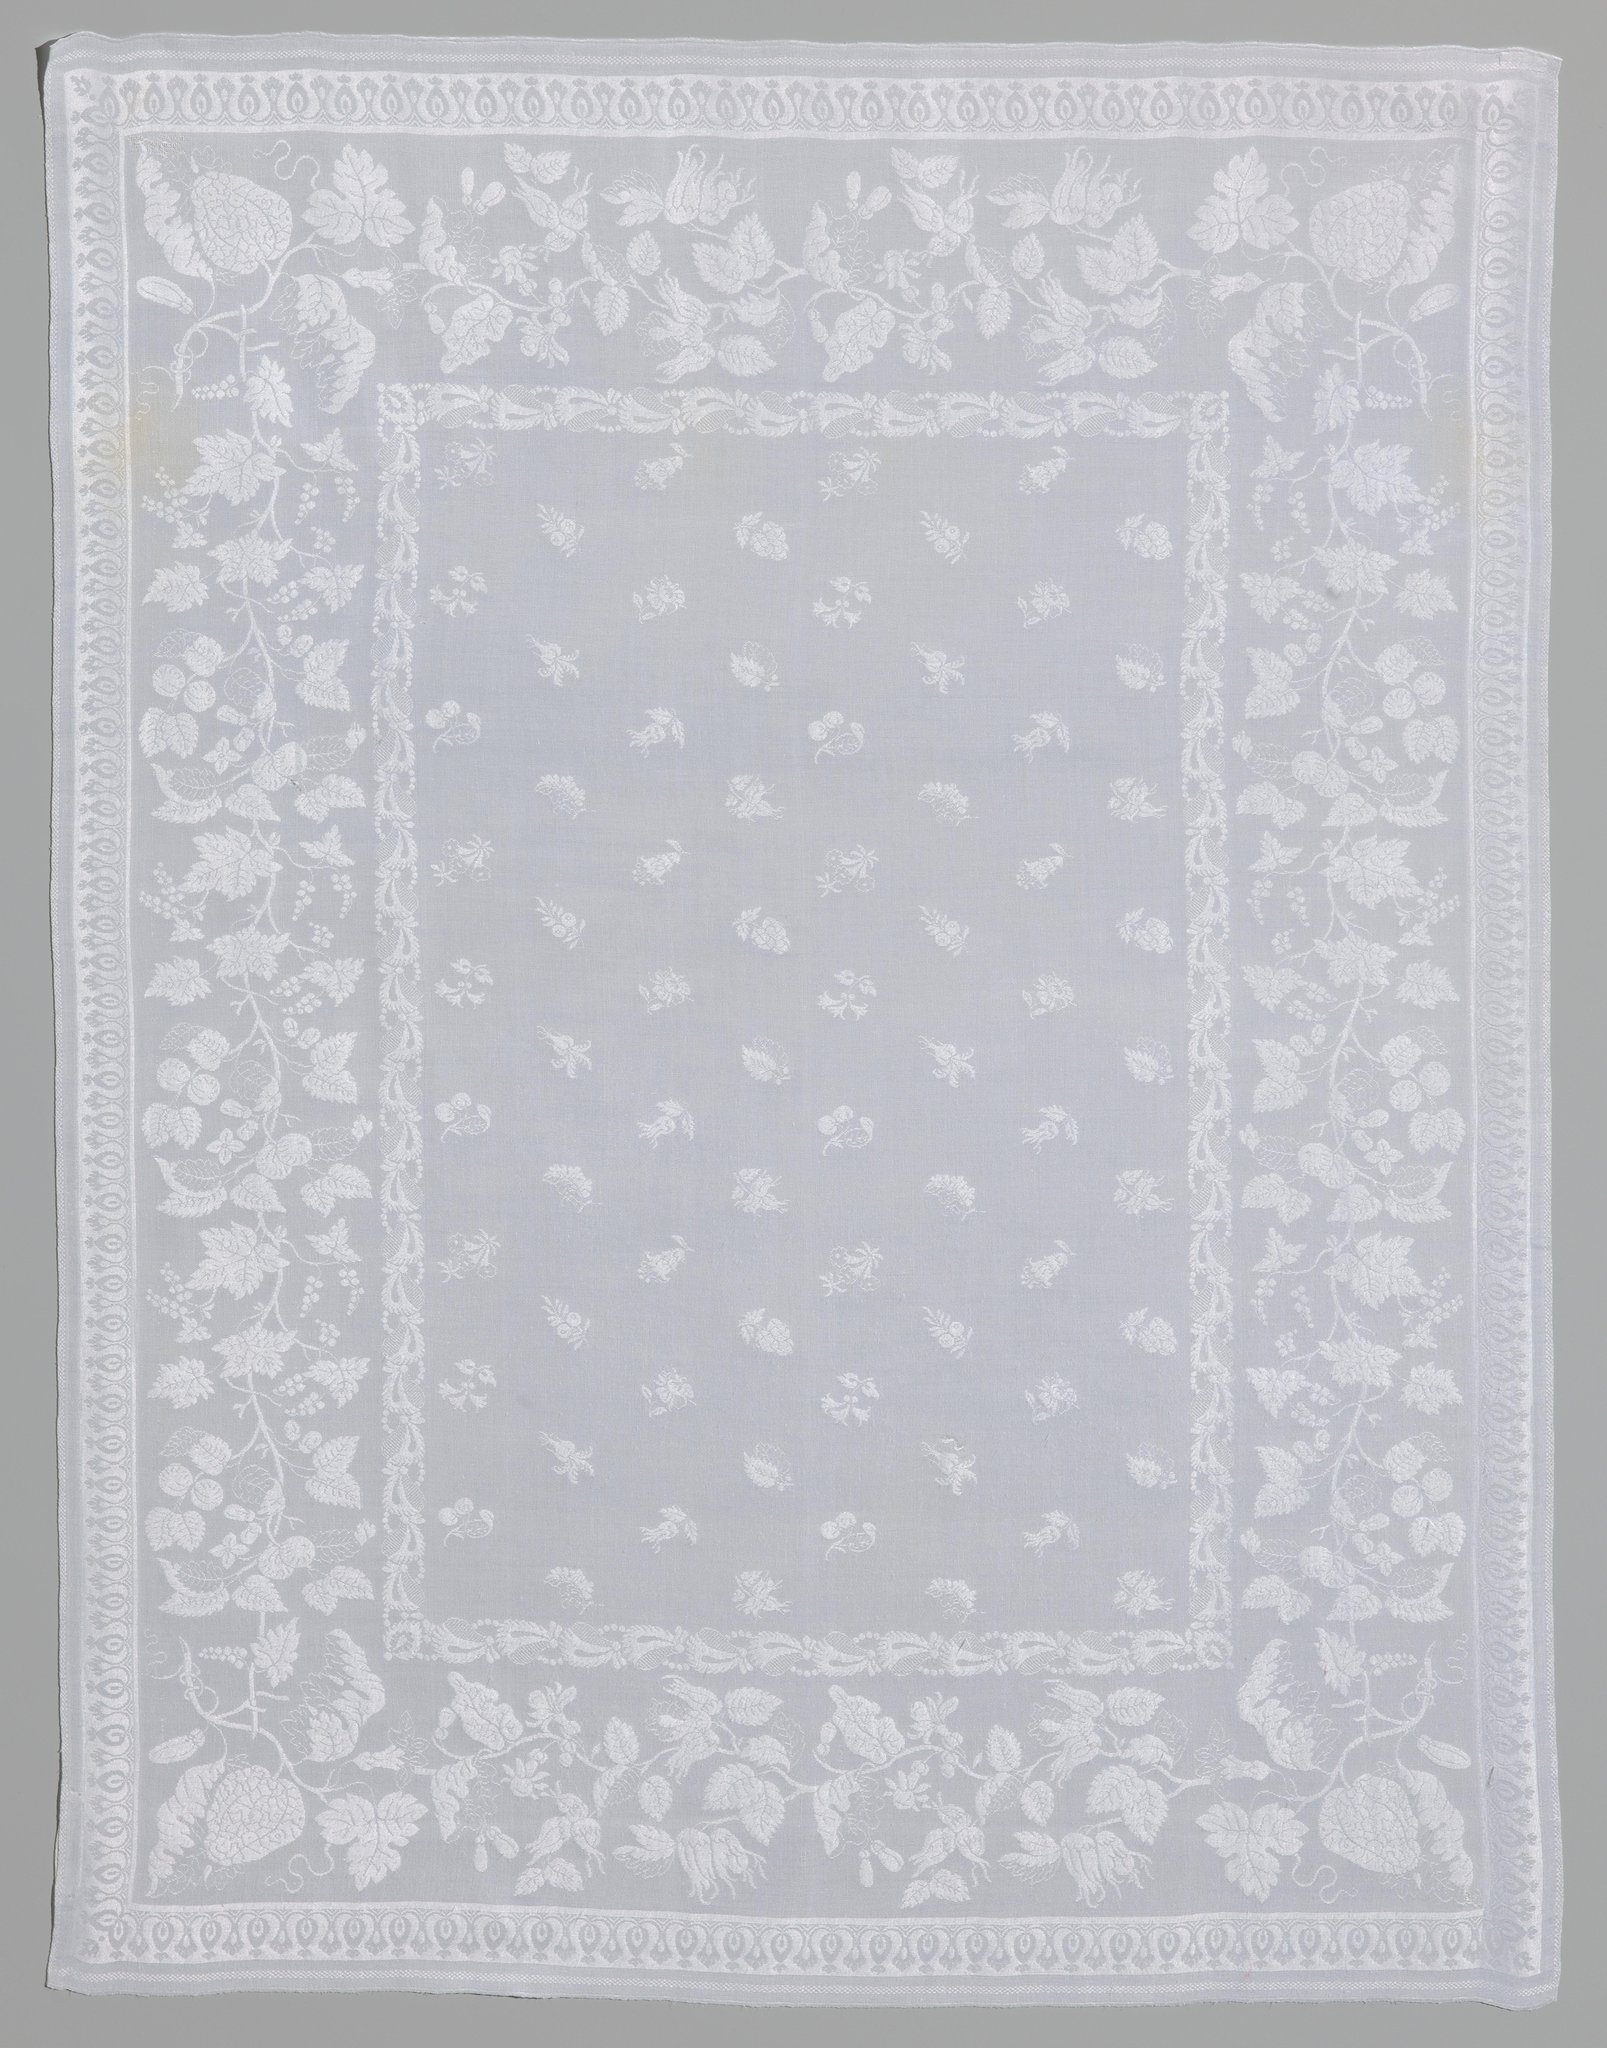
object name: napkin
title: Servet met patroon van diverse vruchten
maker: Anonymous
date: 1800-1900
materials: linen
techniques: damask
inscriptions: mark: ‘36’, label: ‘R.M. A'dam’, monogram: ‘TvBF’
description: Servet van linnendamast met patroon van diverse vruchten en bloemen op het middenveld.